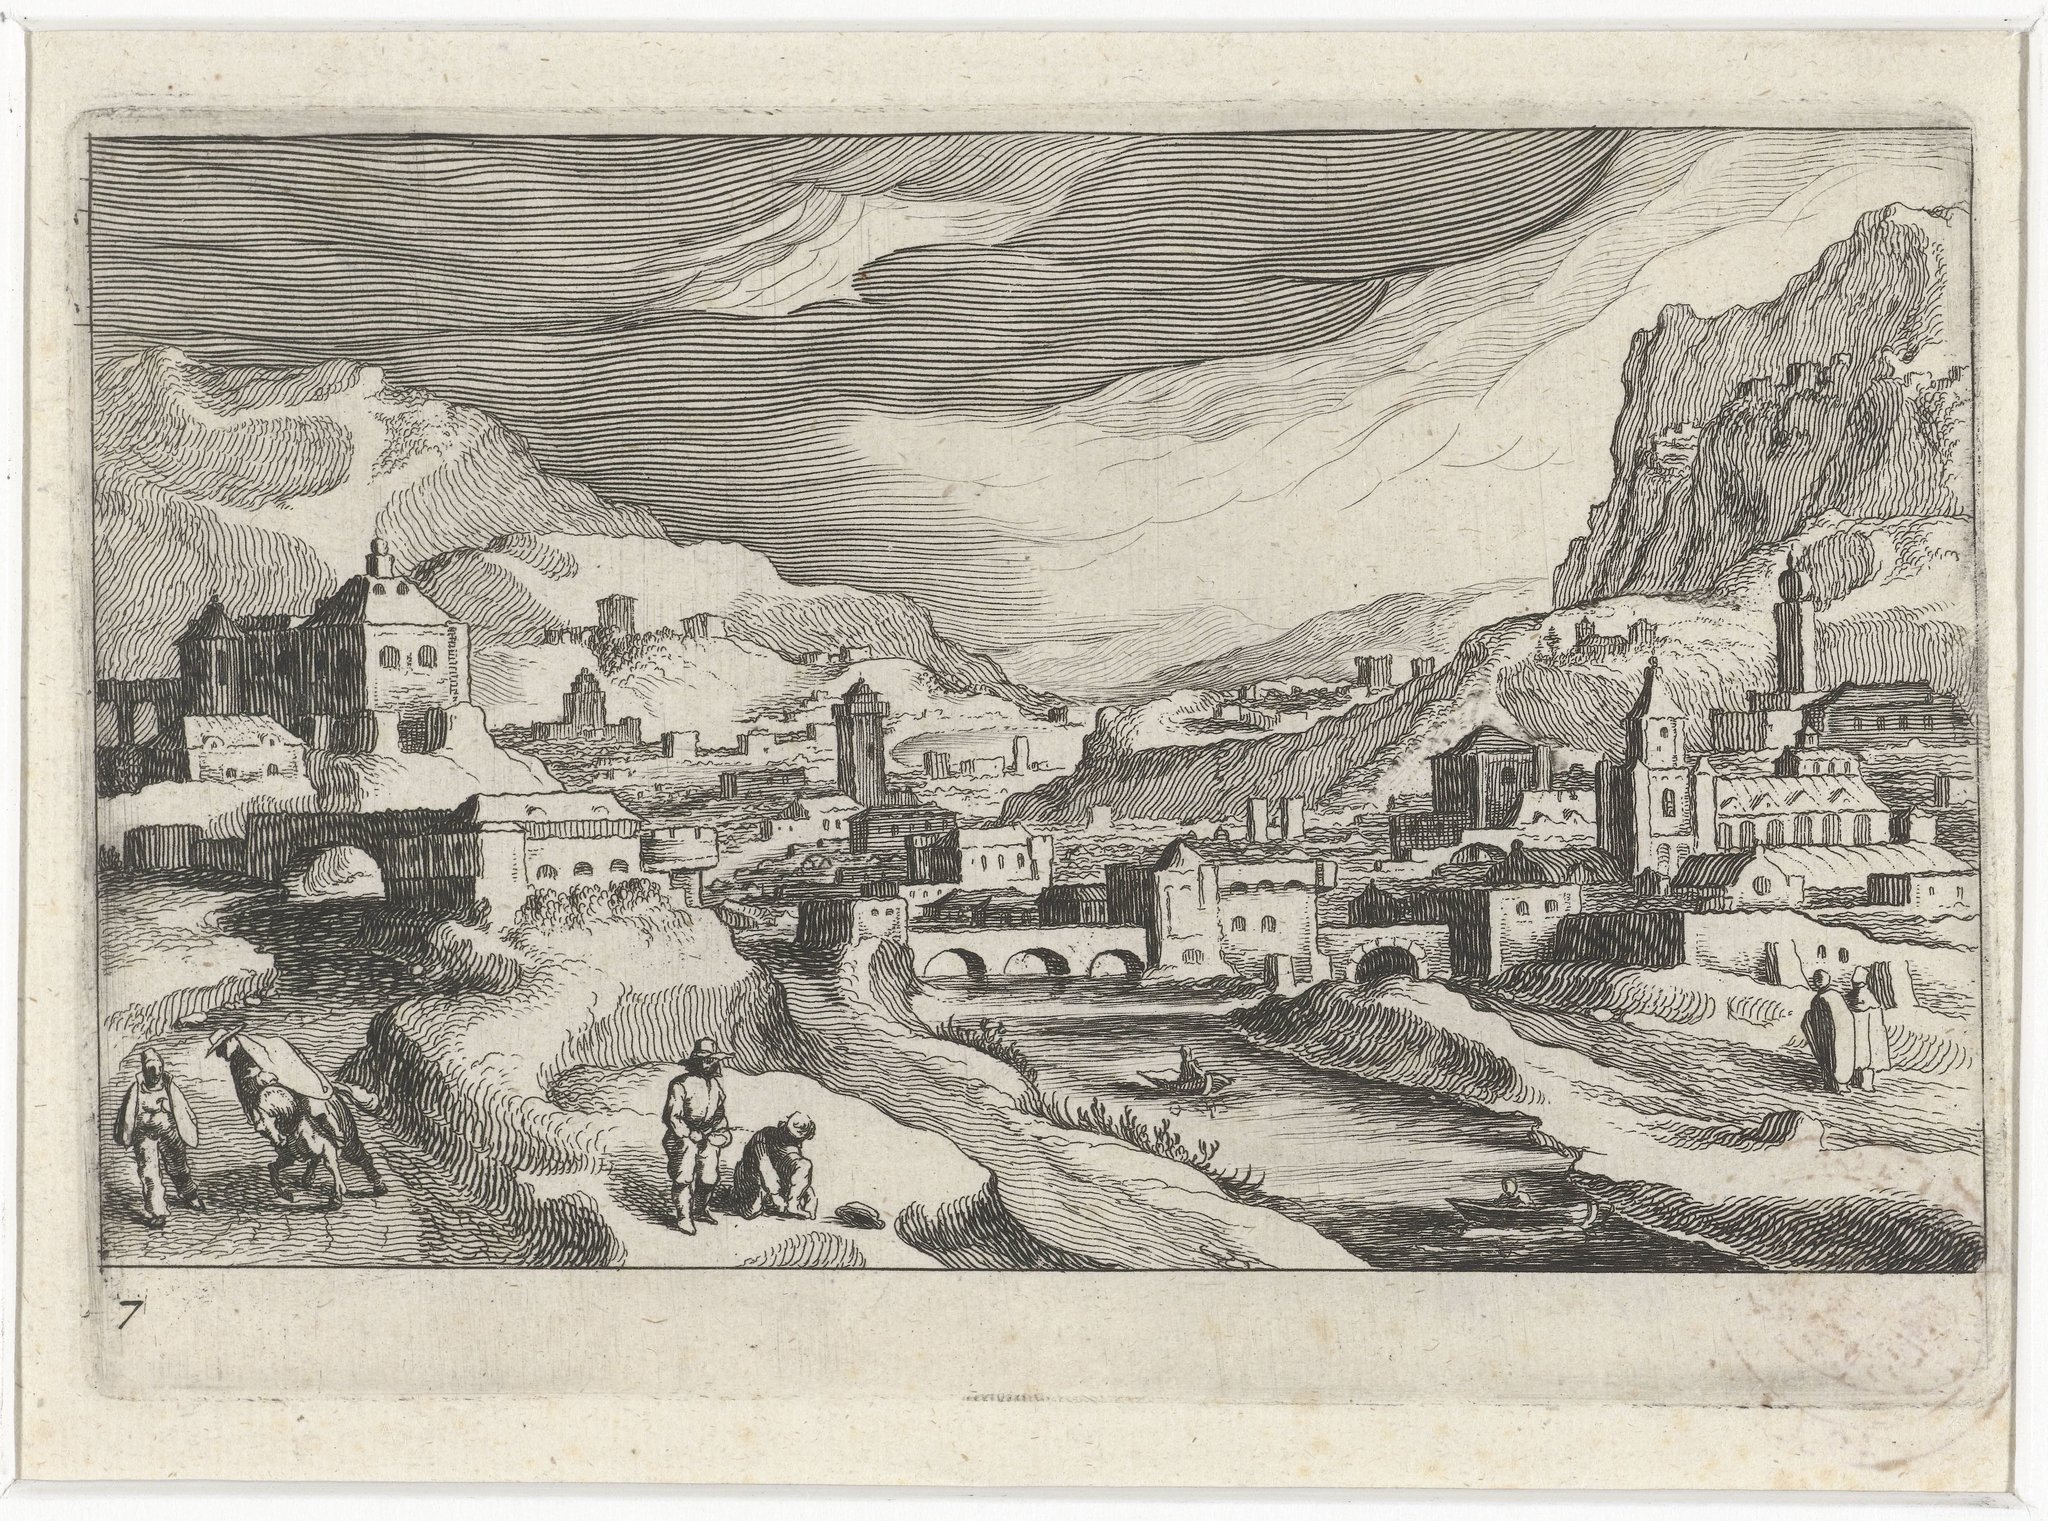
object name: print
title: Zuid-Europese landschappen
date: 1611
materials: paper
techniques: etching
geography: northern netherlands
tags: city-view, and landscape with man-made constructions (+ city(-scape) with figures, staffage)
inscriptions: collector's mark: Lugt 240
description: In een weids, heuvelachtig rivierlandschap ligt een stad. Op de voorgrond trekt een man zijn schoen aan, terwijl naast hem een man staat te plassen.